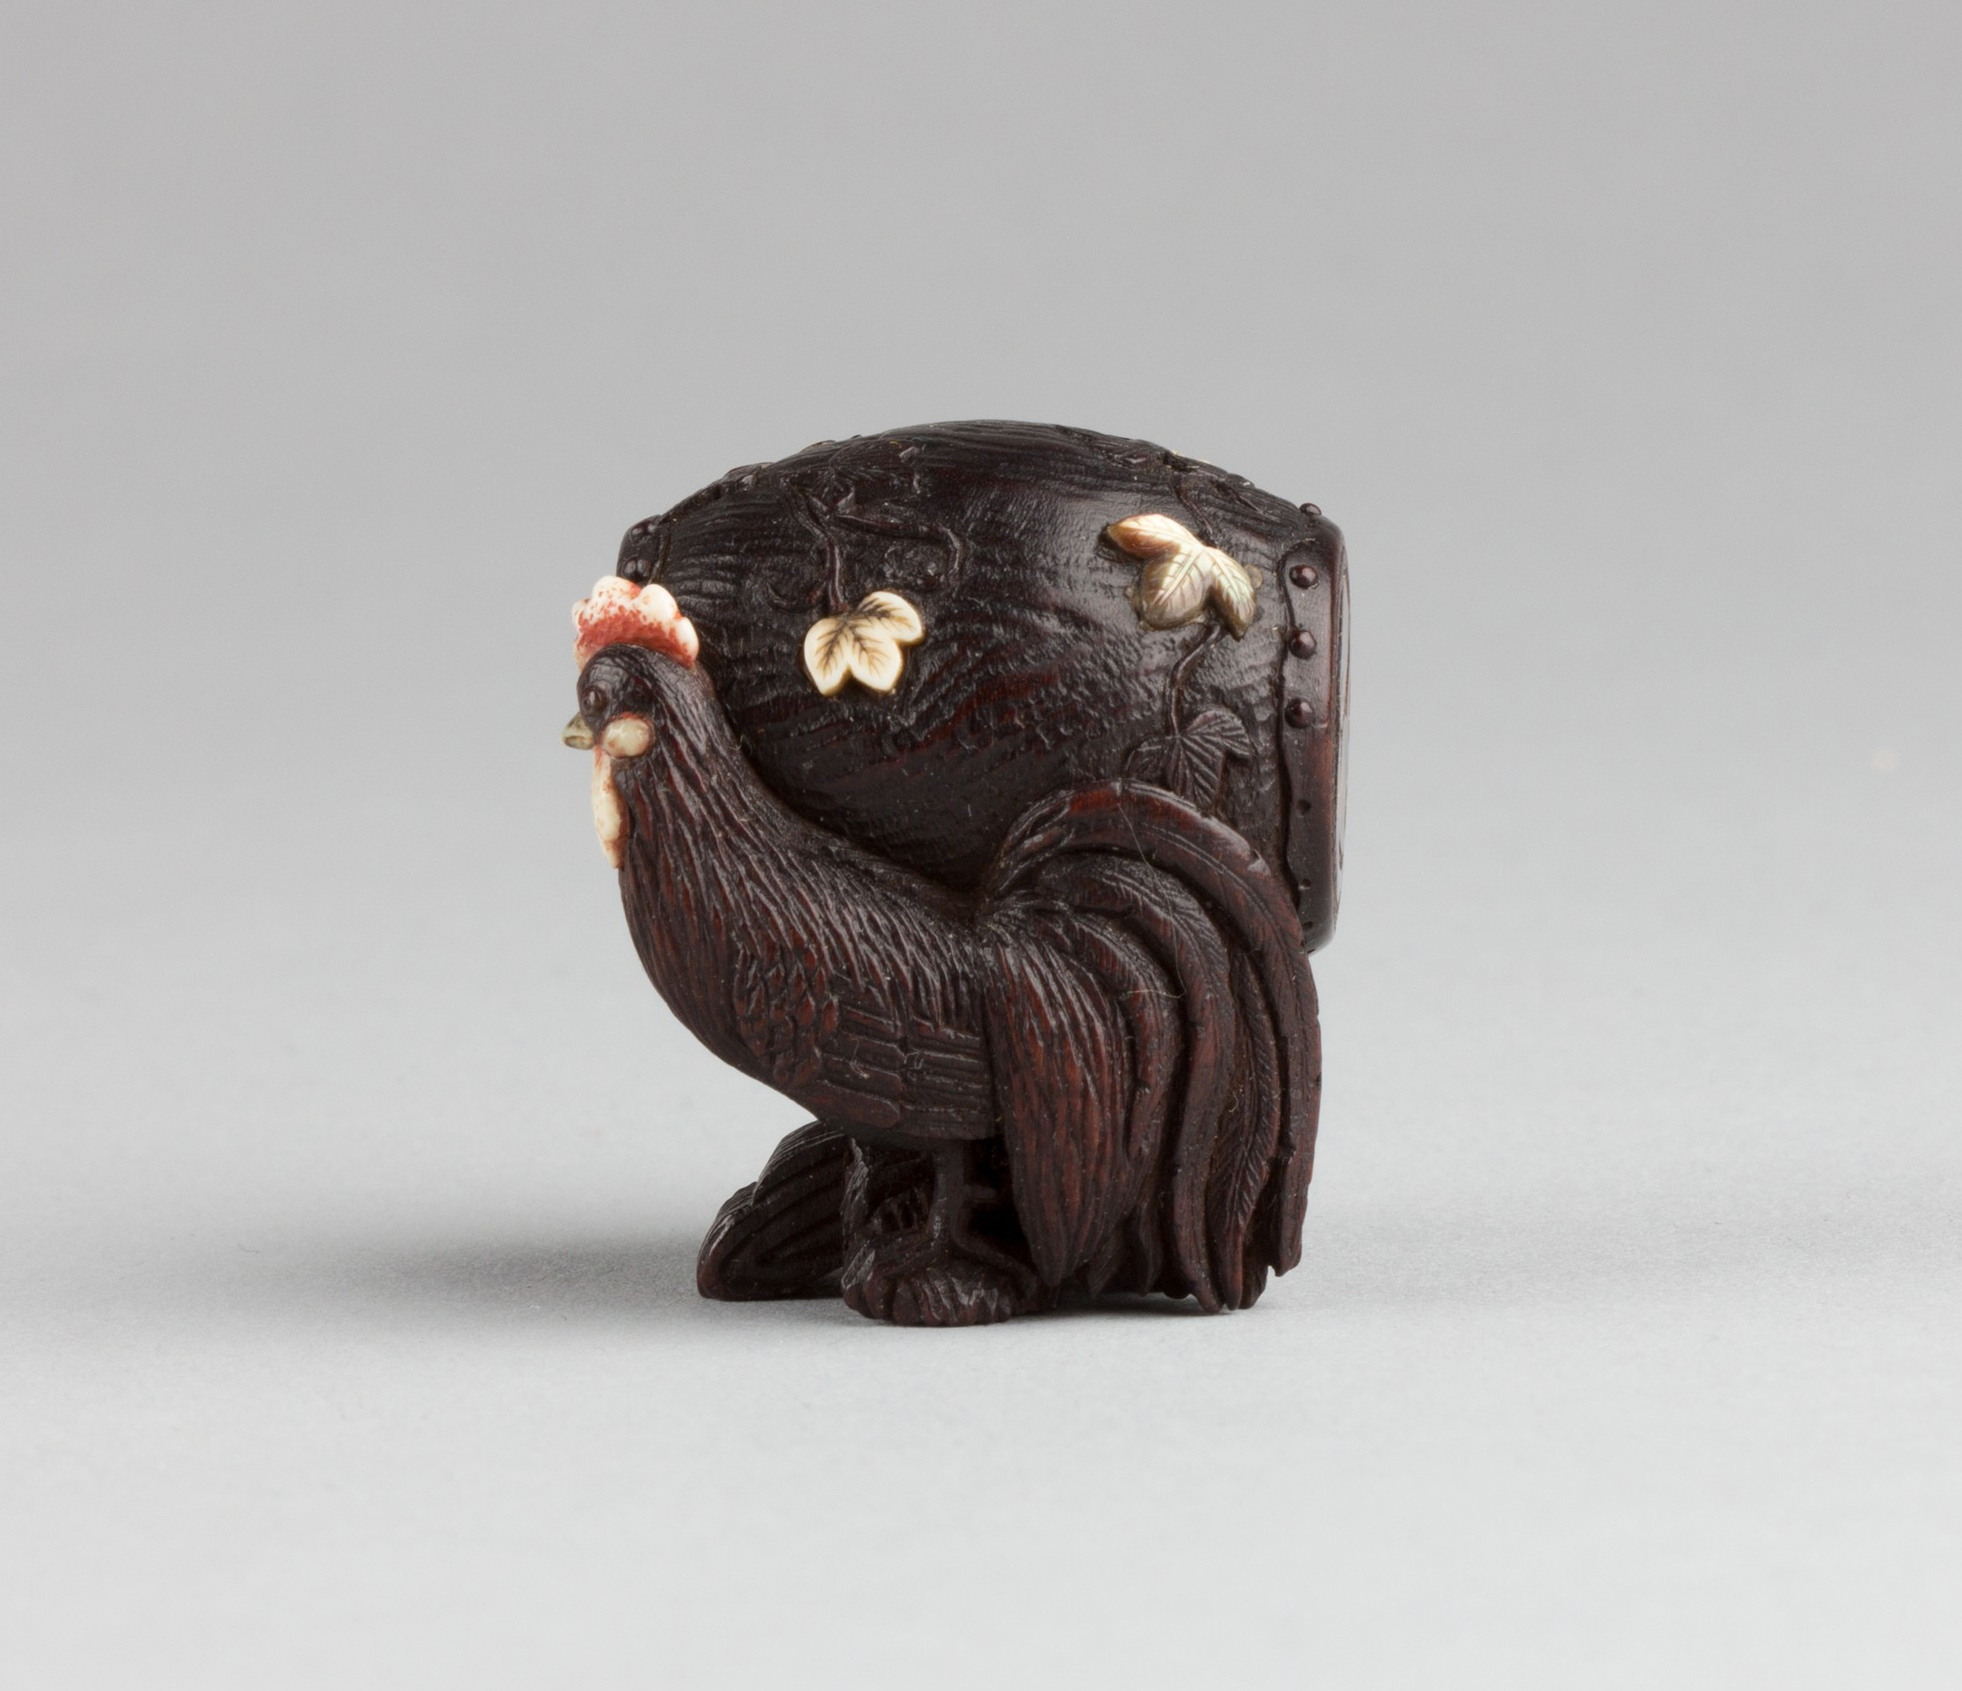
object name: netsuke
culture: japanese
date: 1801-1900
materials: ivory, mother of pearl, wood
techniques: inlay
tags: drums,roosters